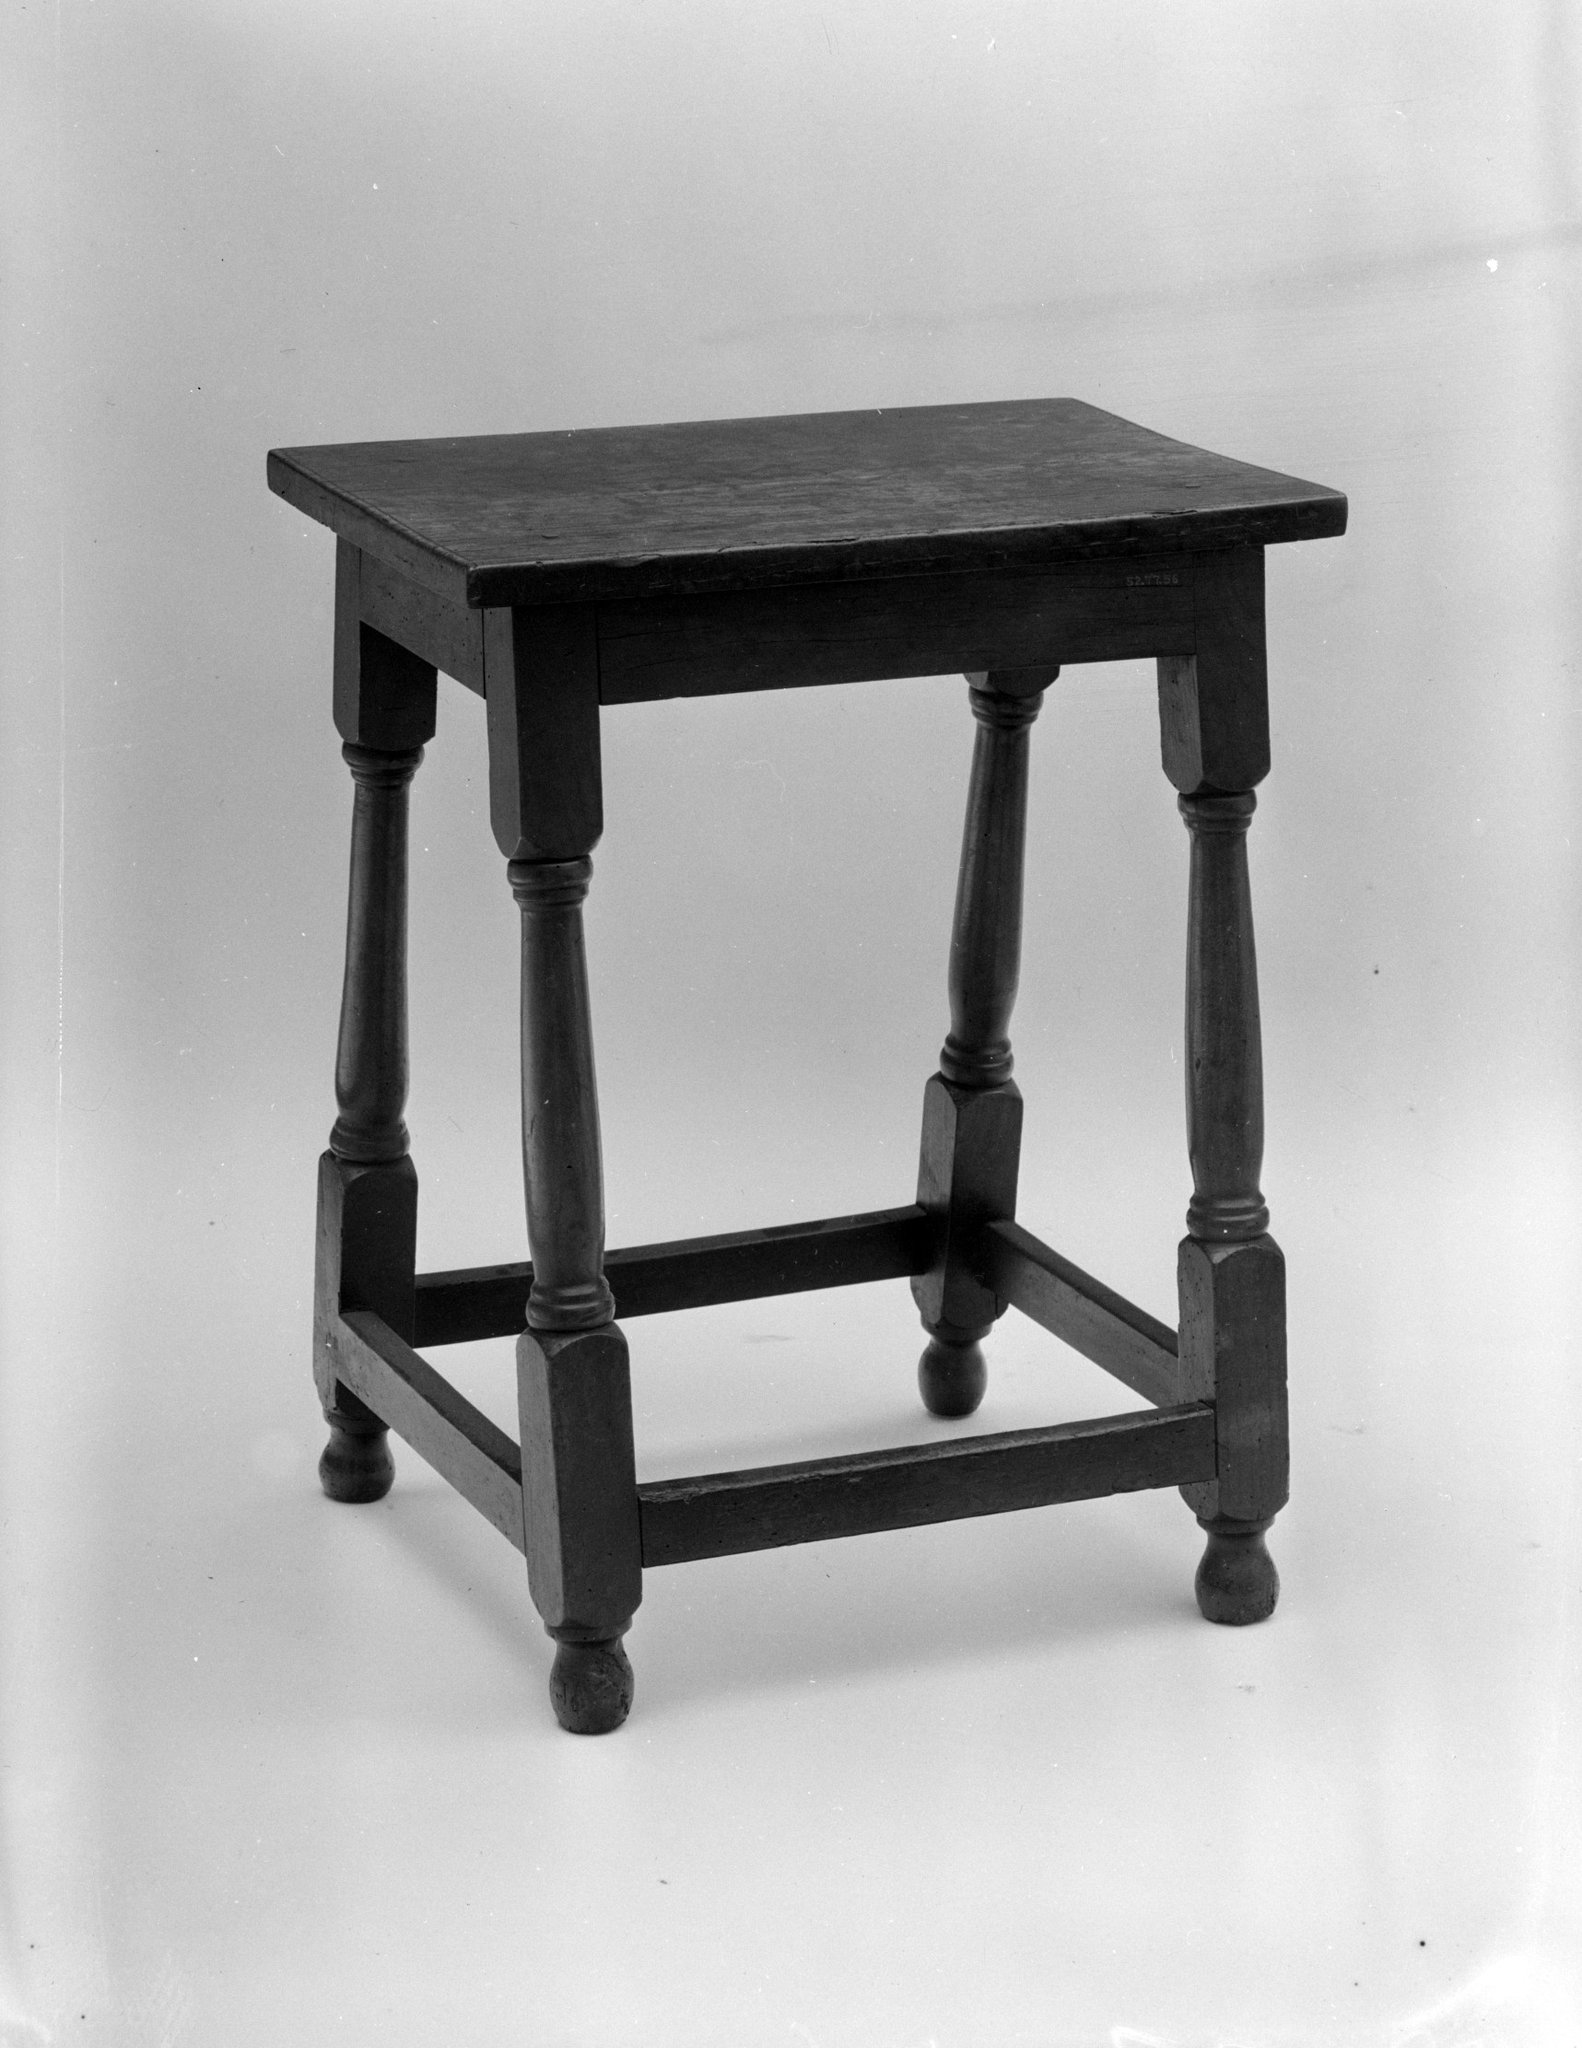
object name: joint stool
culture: american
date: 1725-1750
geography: united states